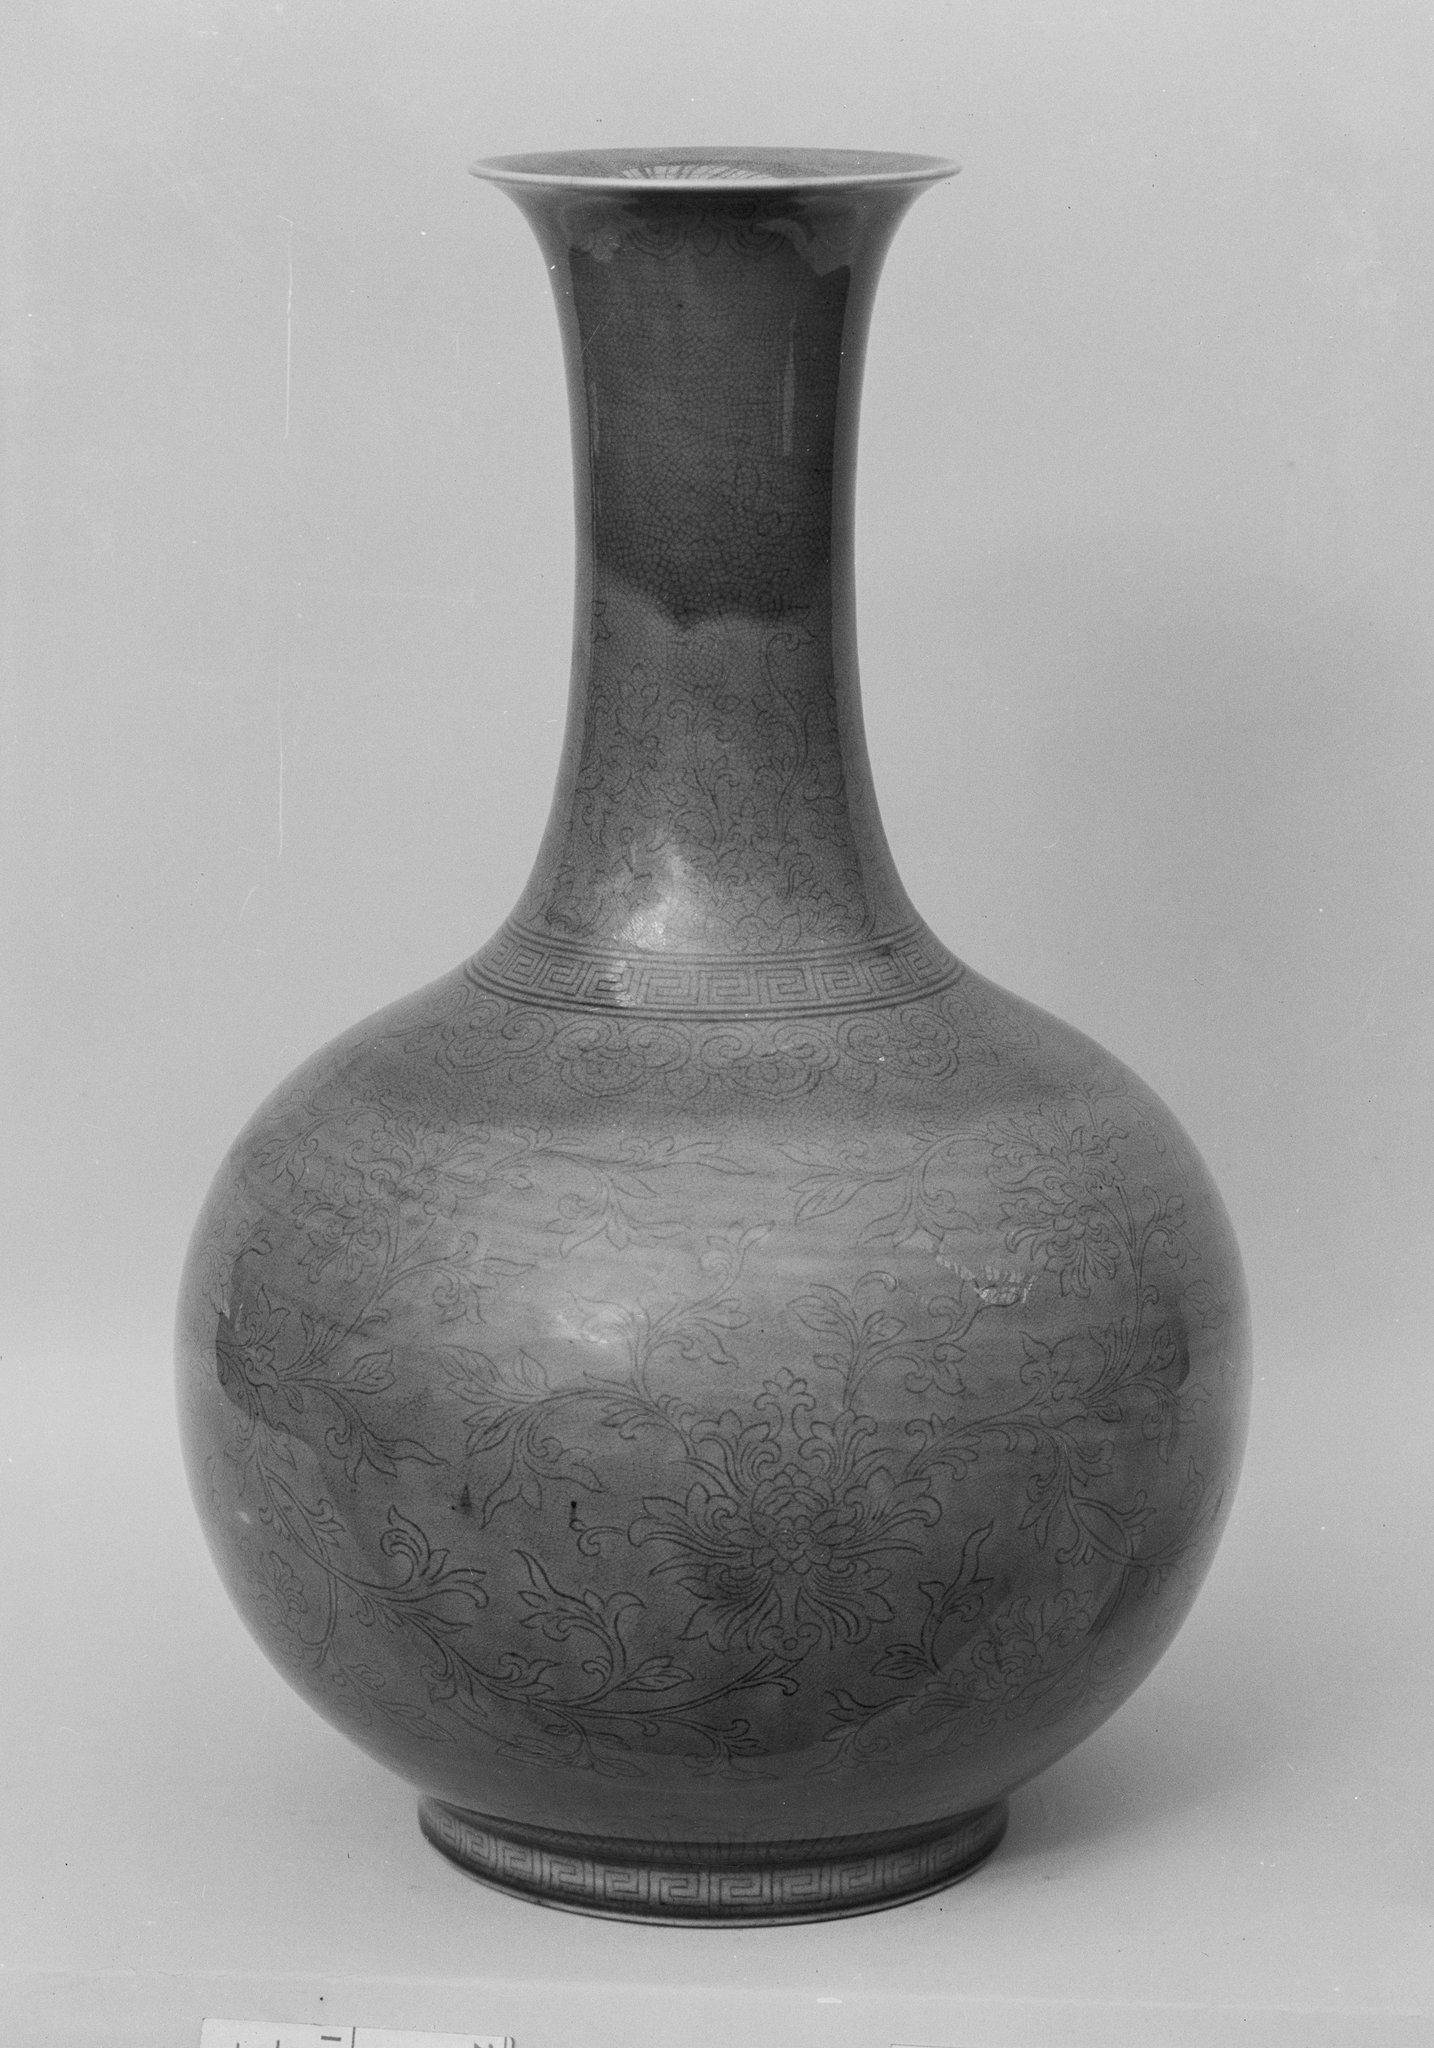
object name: vase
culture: chinese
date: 1796-1820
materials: glaze, porcelain